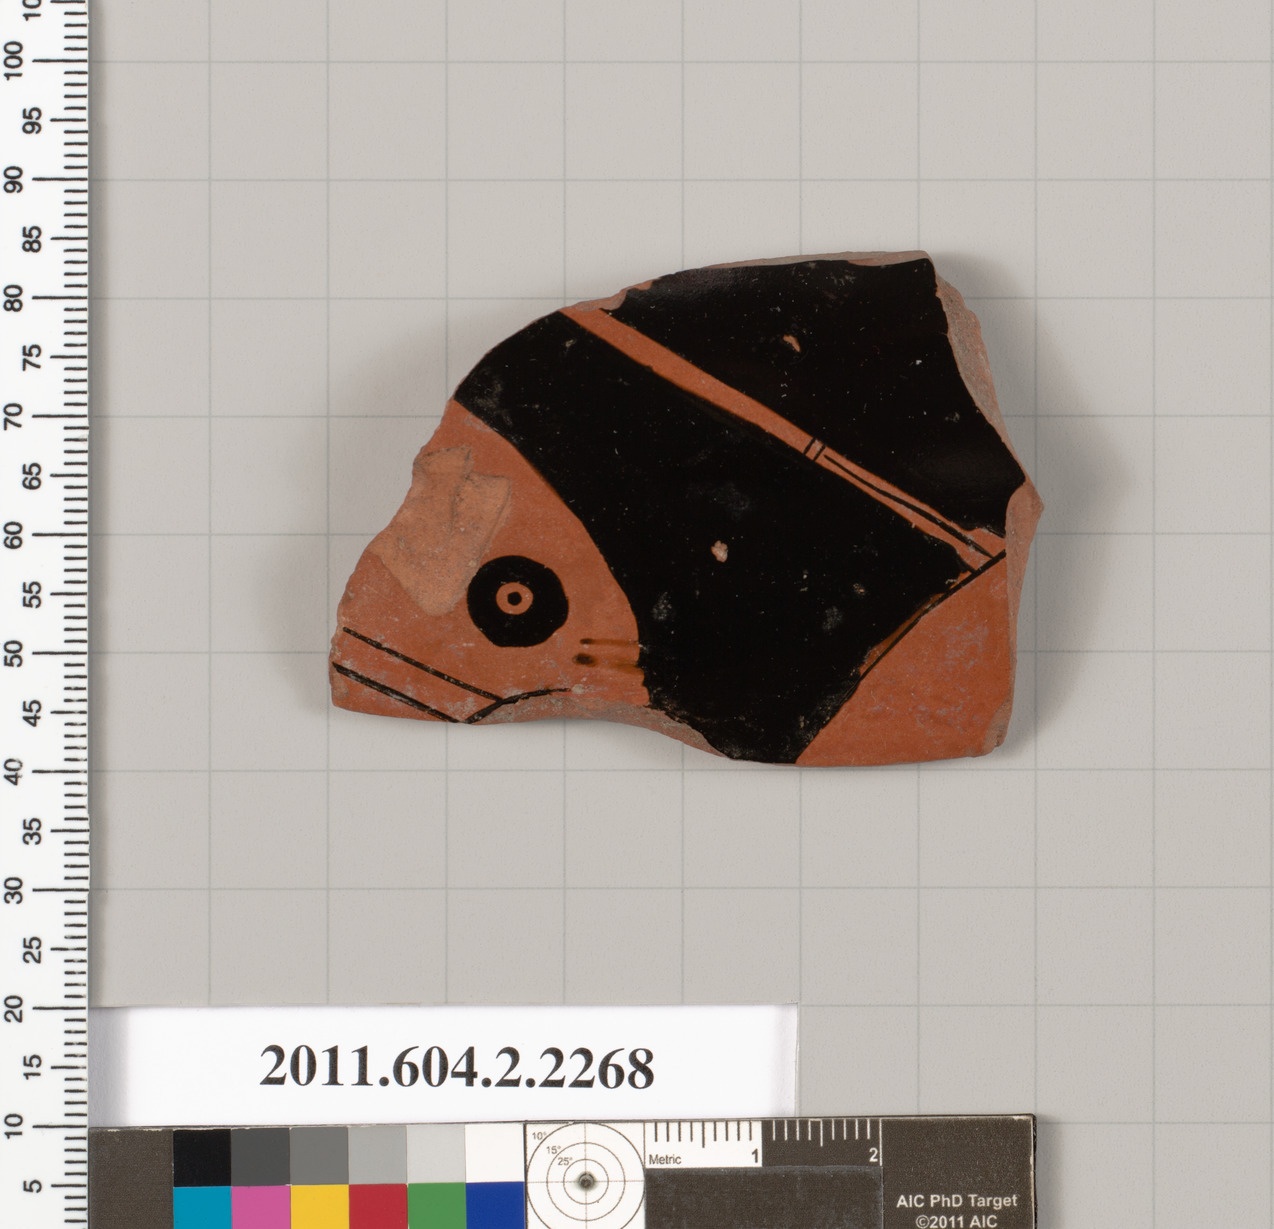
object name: column krater fragment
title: Terracotta fragment of a column-krater (bowl for mixing wine and water)?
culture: greek, attic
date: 475-451 BCE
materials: terracotta